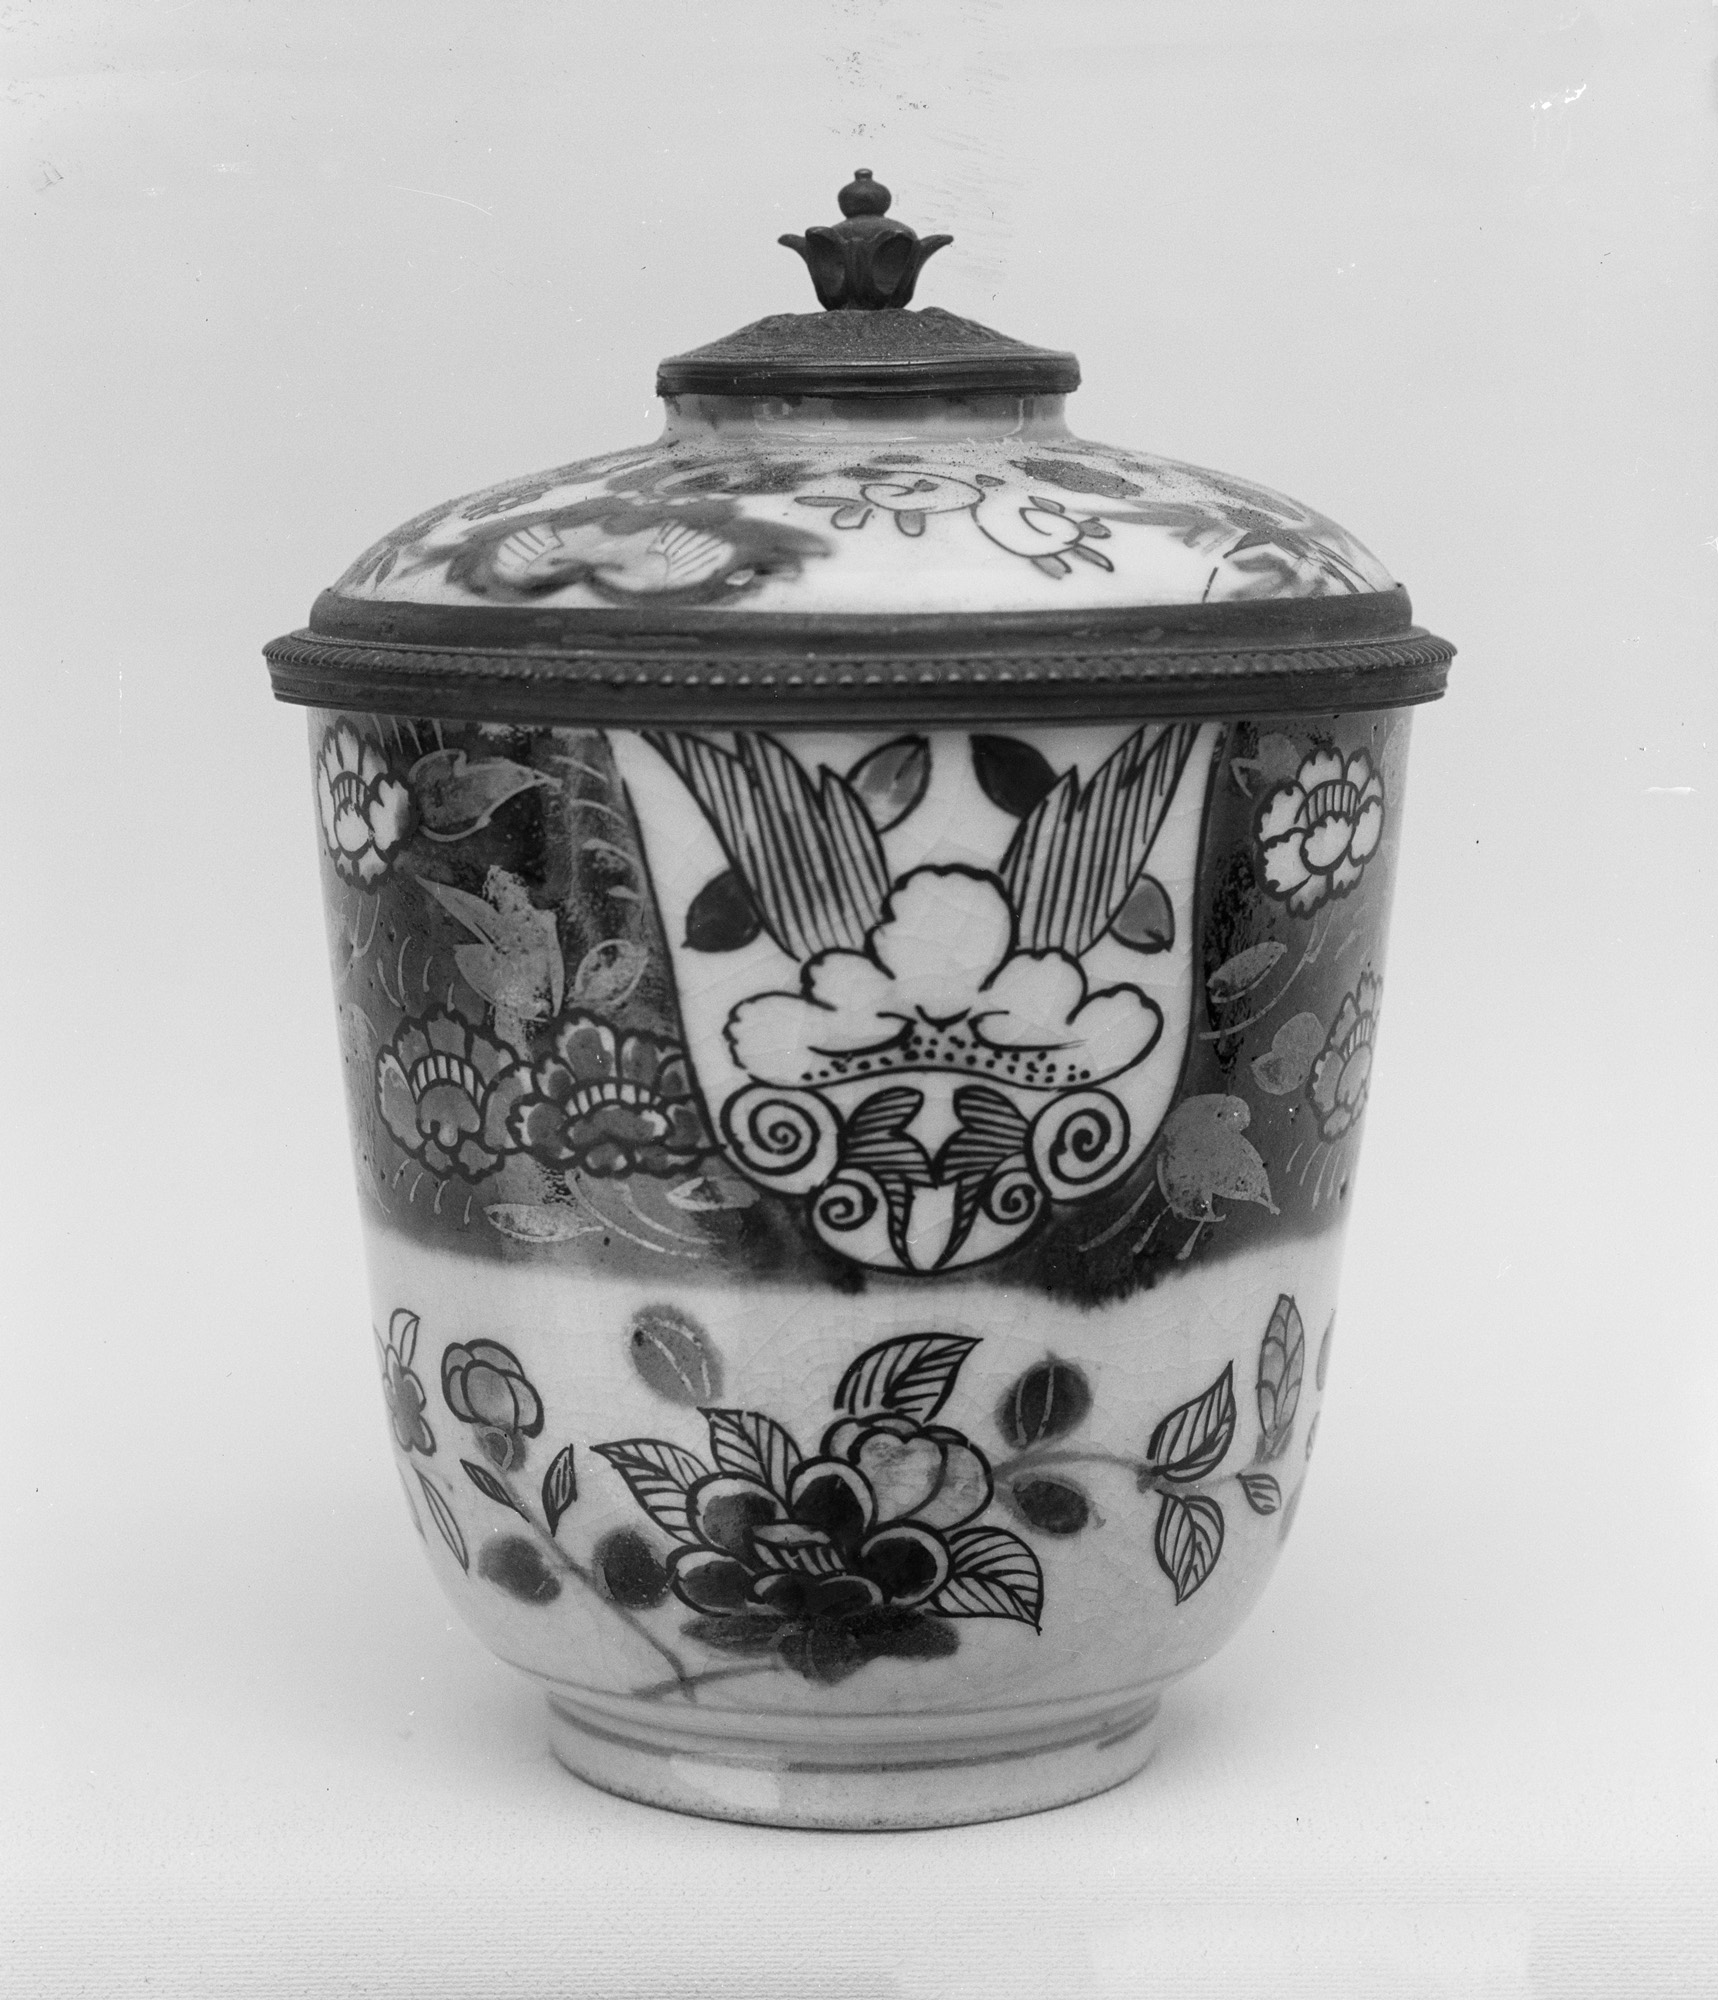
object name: cup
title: Cup and Silver Mounted Cover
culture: japanese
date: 1701-1800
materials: glaze, gold, iron, porcelain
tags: flowers